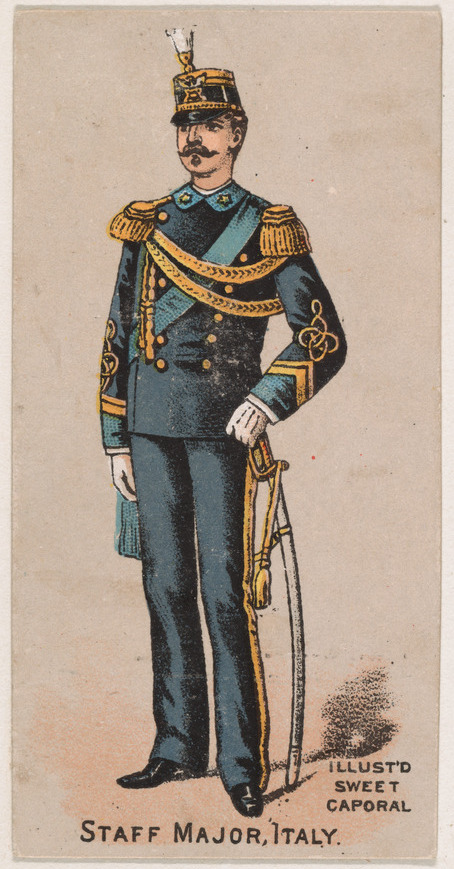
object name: print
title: Staff Major, Italy, from the Military Series (N224) issued by Kinney Tobacco Company to promote Sweet Caporal Cigarettes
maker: kinney brothers tobacco company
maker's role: publisher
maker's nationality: american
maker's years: 1869-2011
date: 1888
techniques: color lithograph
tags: military,swords,men